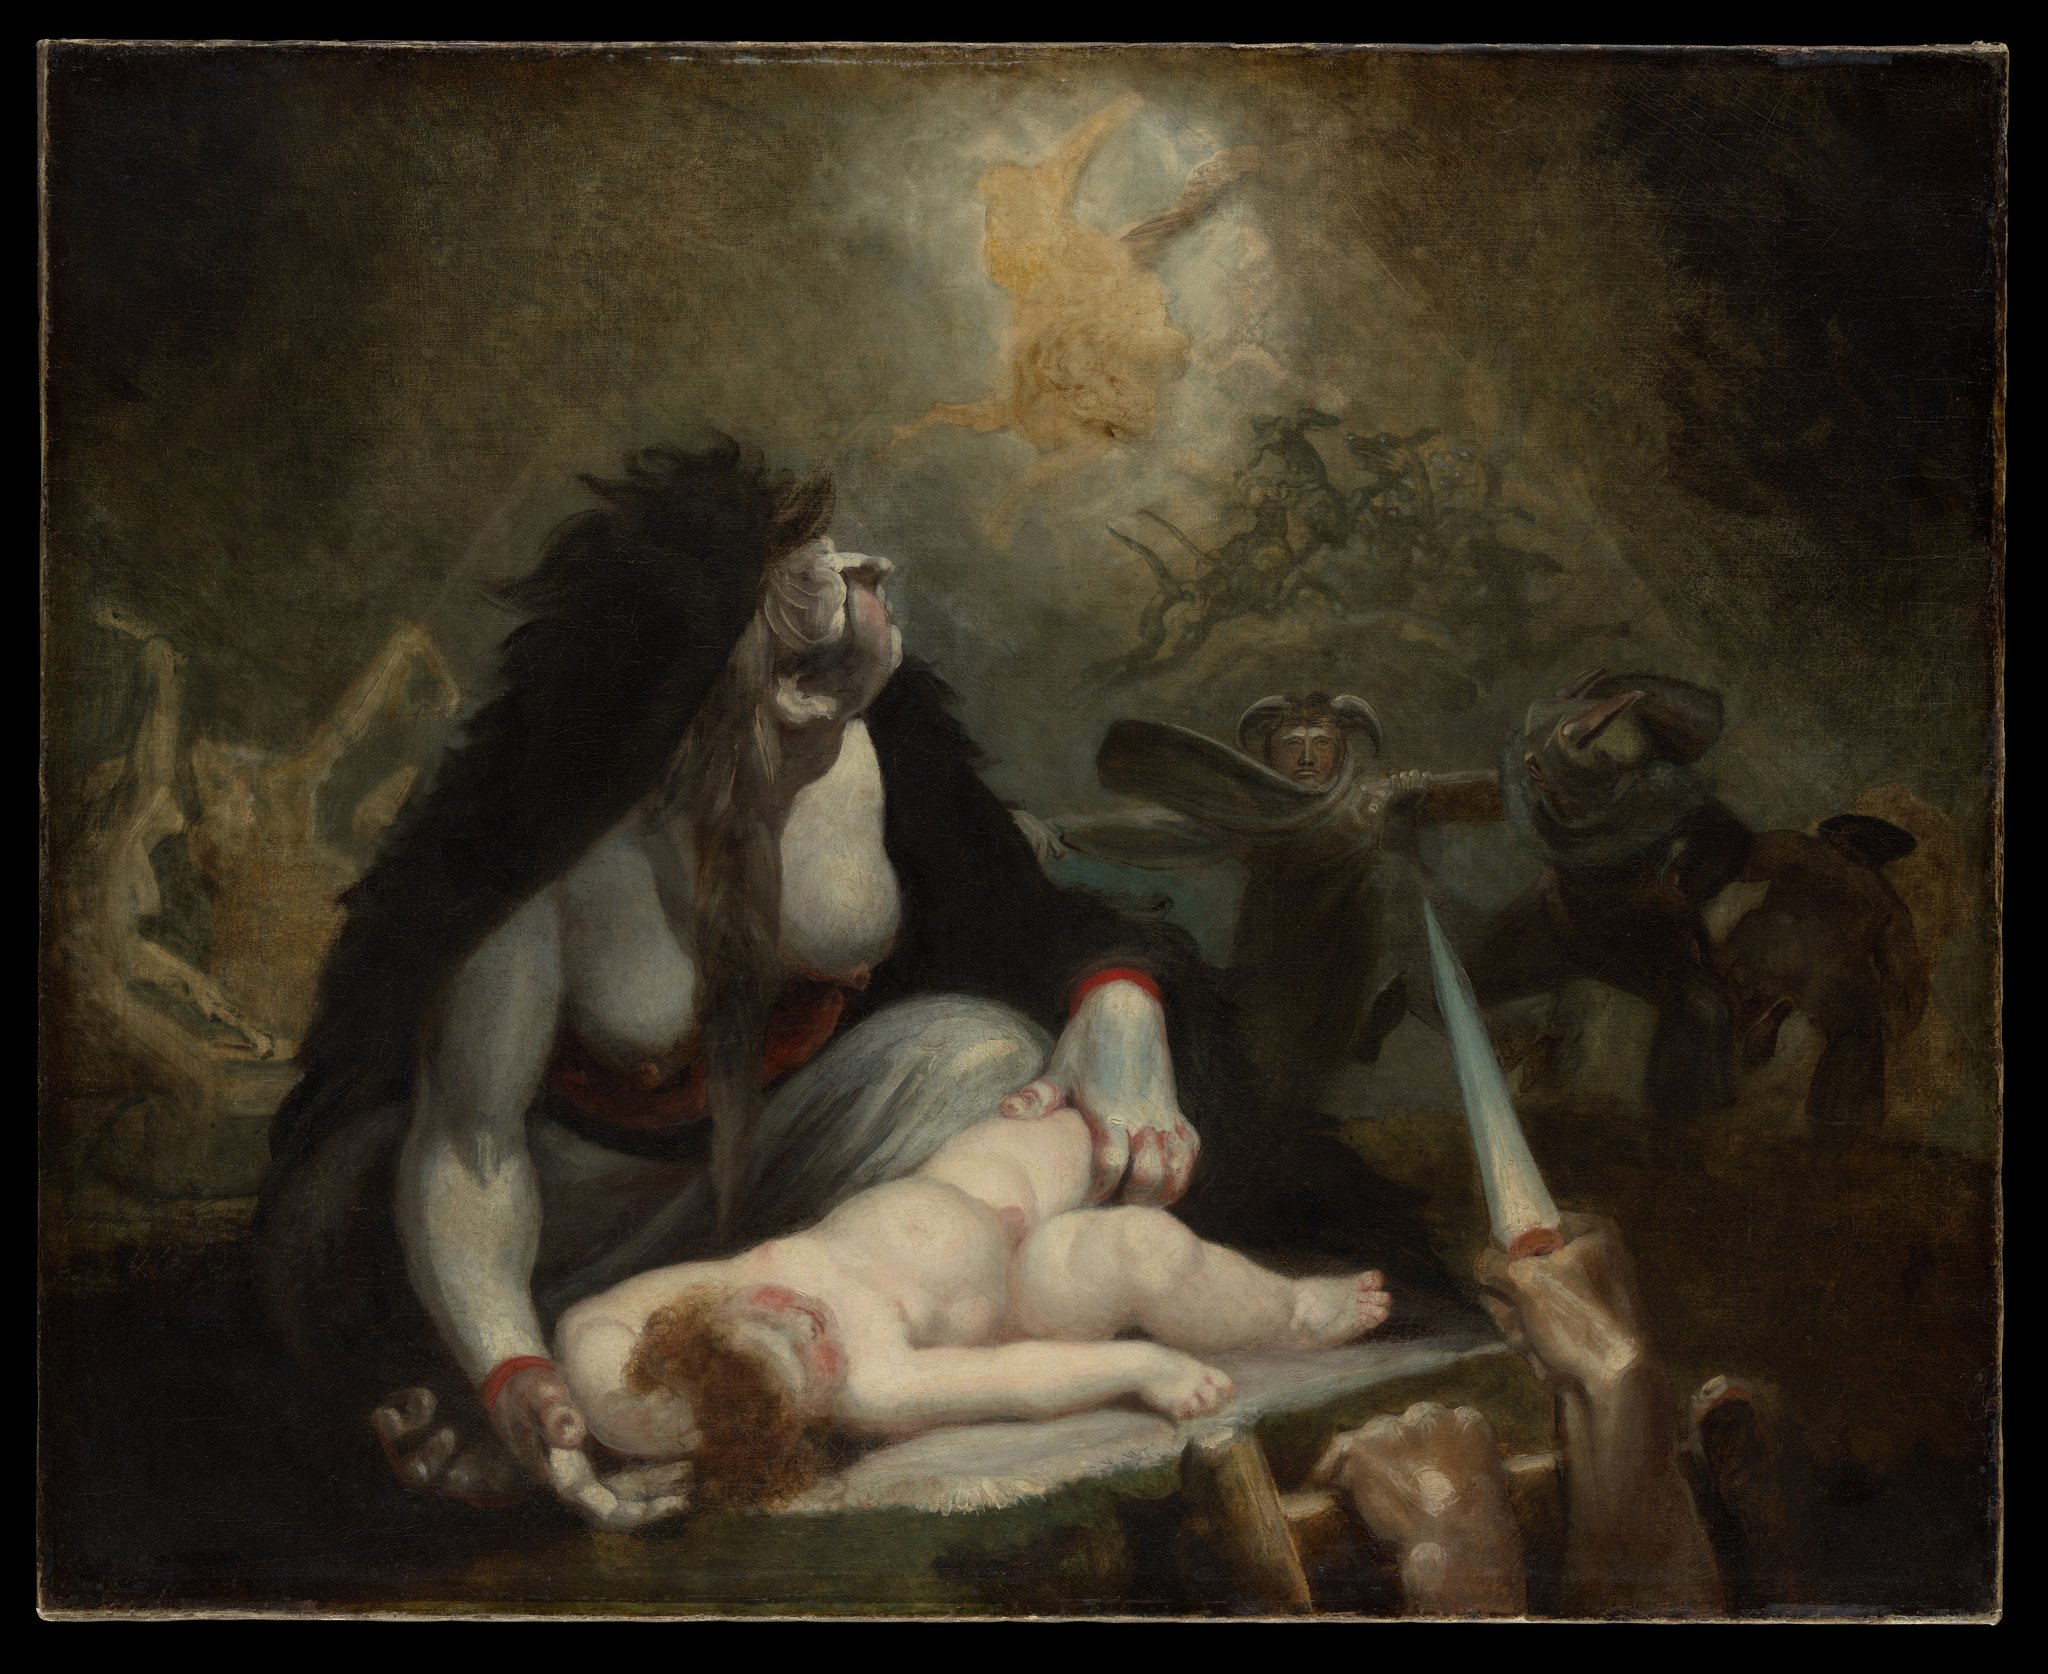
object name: painting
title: The Night-Hag Visiting Lapland Witches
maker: henry fuseli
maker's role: artist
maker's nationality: swiss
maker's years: 1741-1825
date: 1796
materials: canvas, oil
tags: knives,children,female nudes,witches